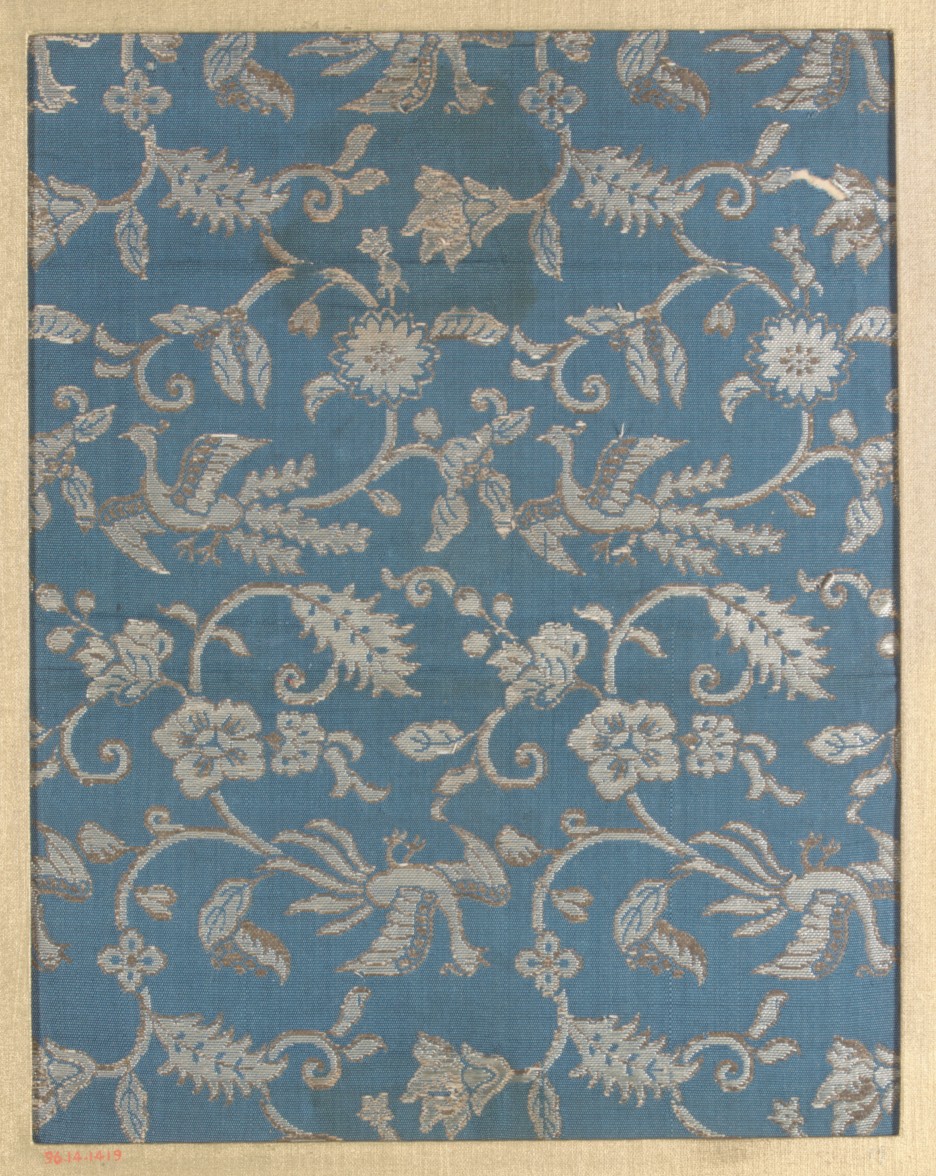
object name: piece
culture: japanese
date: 1701-1900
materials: silk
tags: flowers